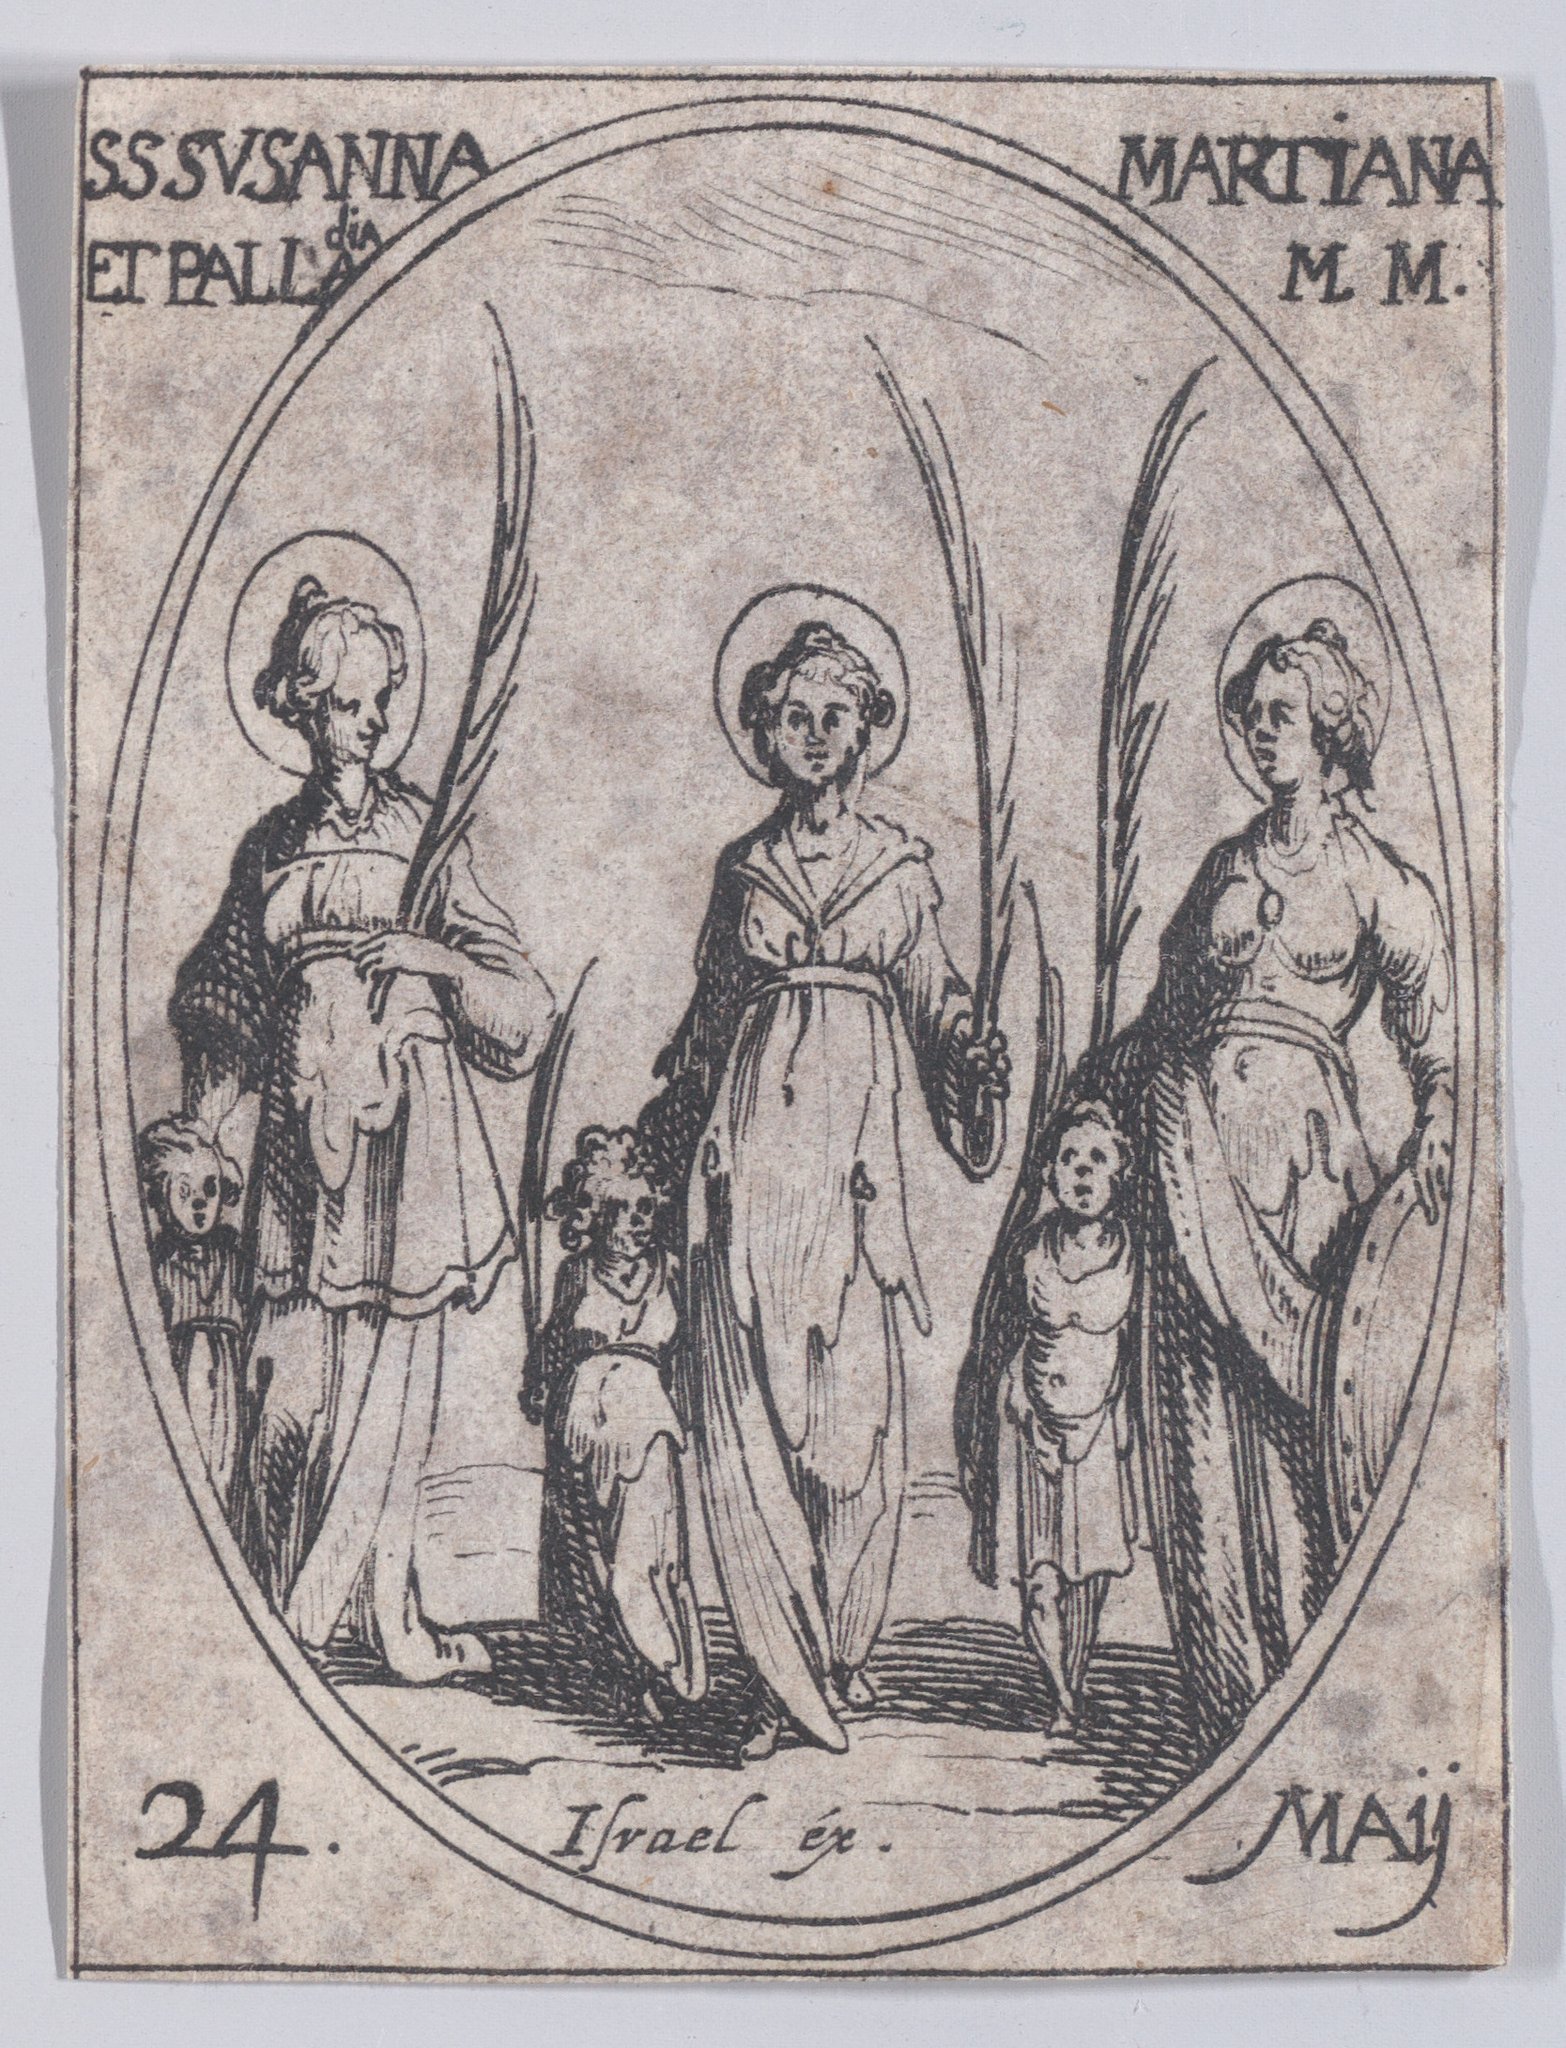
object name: print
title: Ste. Suzanne, Ste. Marienne et Ste. Palladie (St. Susanna, St. Mariana, and St. Palladia), May 24th, from "Les Images De Tous Les Saincts et Saintes de L'Année" (Images of All of the Saints and Religious Events of the Year)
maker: jacques callot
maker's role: artist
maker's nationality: french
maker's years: 1592-1635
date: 1636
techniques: etching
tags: women,saints